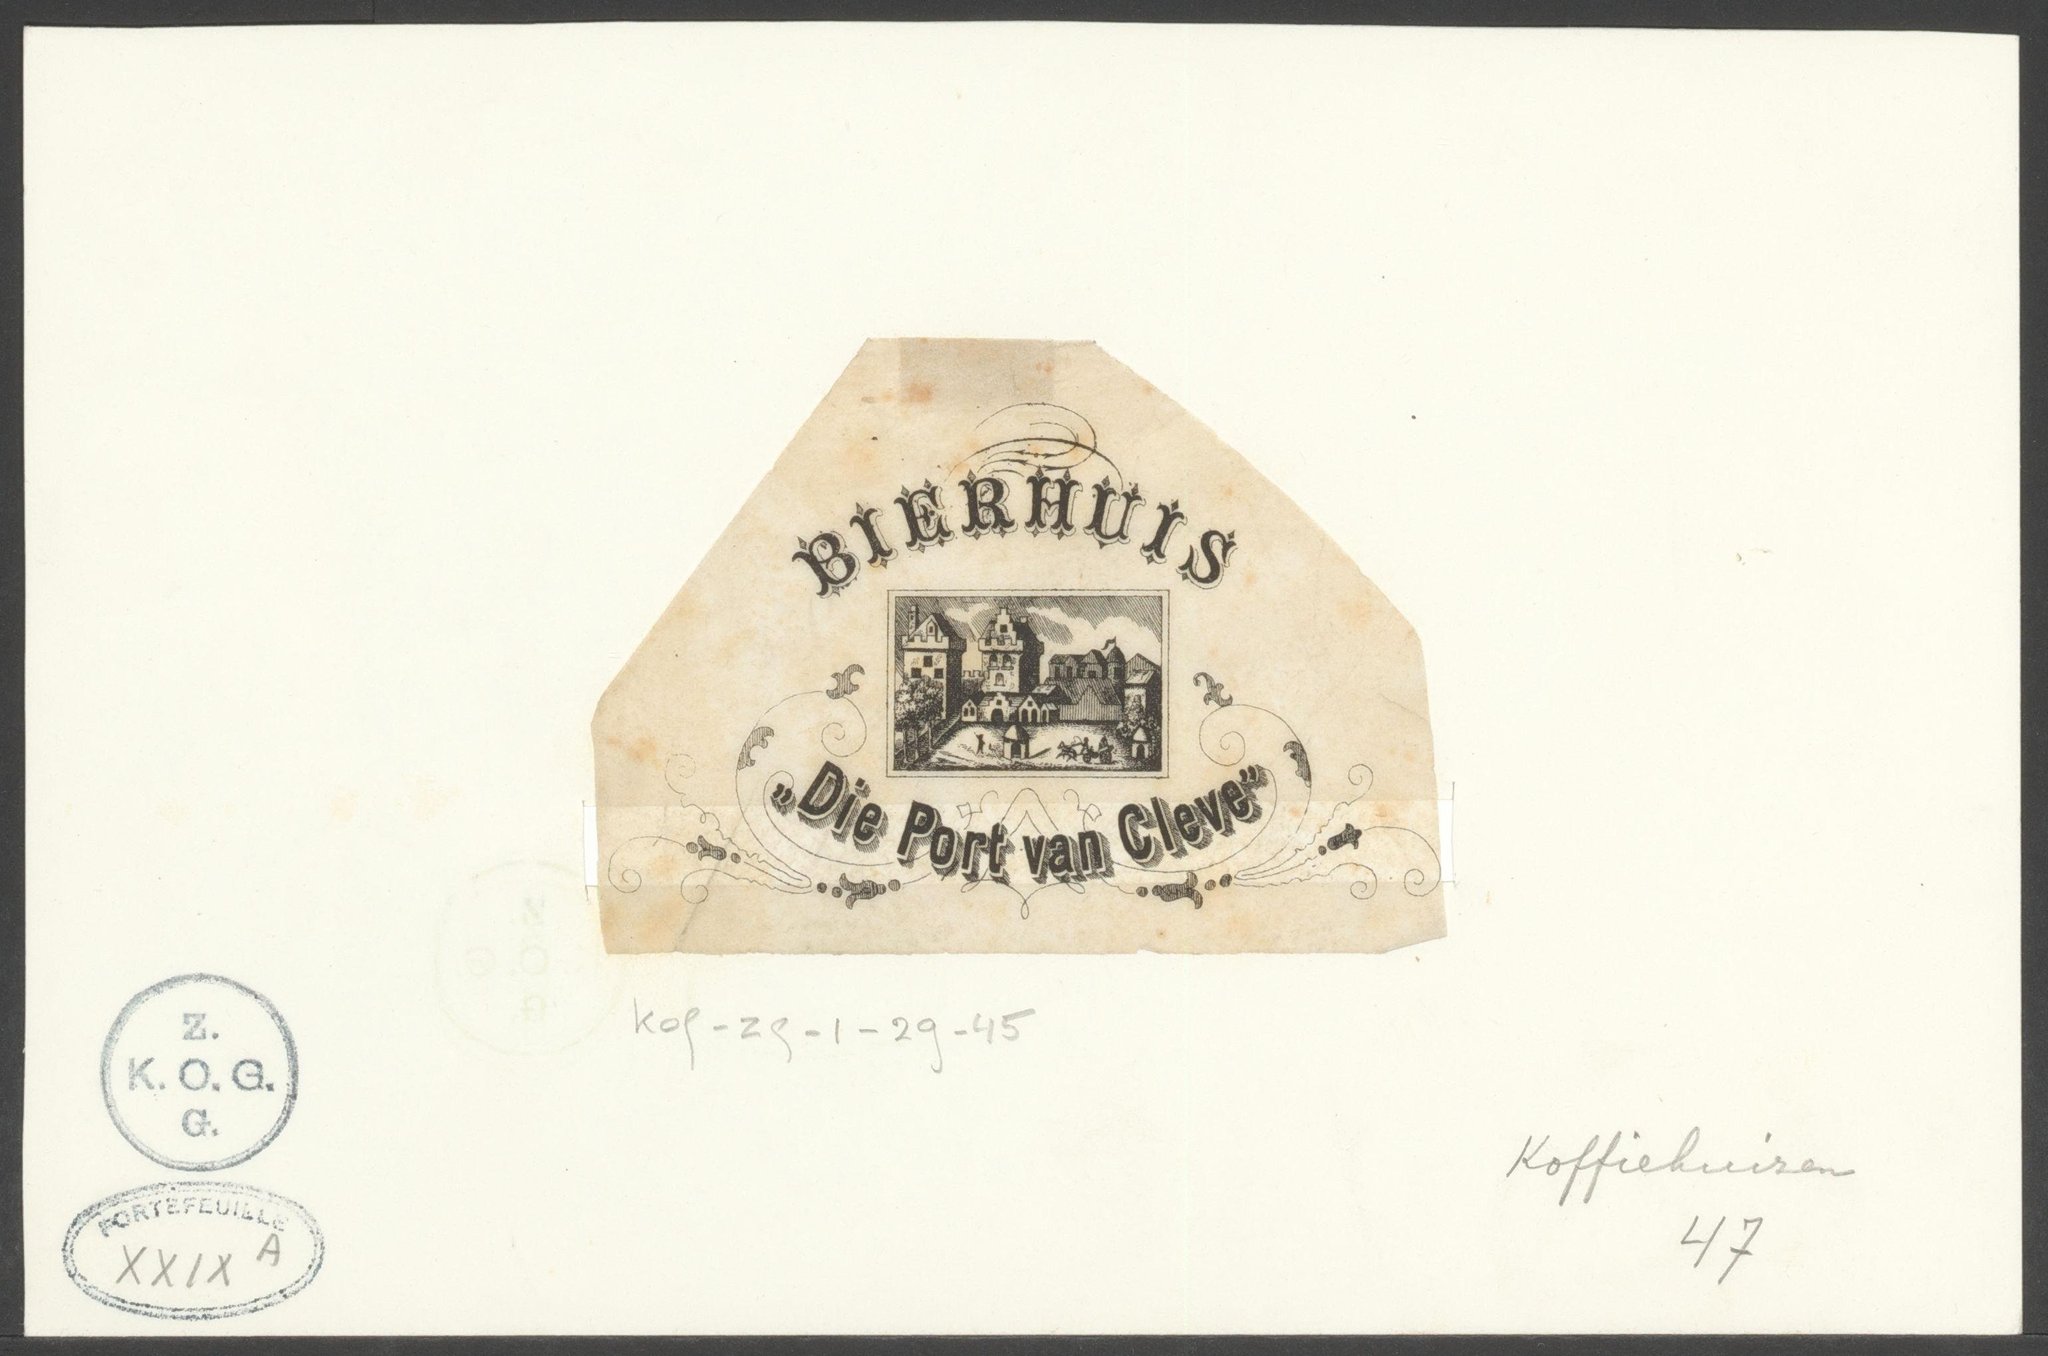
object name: print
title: Bierhuis "Die Port van Cleve"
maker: Anonymous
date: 1800-1899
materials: paper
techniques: lithograph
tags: pub sign, inn sign, inn, coffee-house, public house, etc., hotel, hostelry, inn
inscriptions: stamp, collector's mark: Lugt 1641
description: Onderwerpsrubrieken binnen de Atlas Zeden en Gewoonten: Zeden en gewoonten in engeren zin, Volksleven, Uitspanningslokalen, Koffiehuizen.